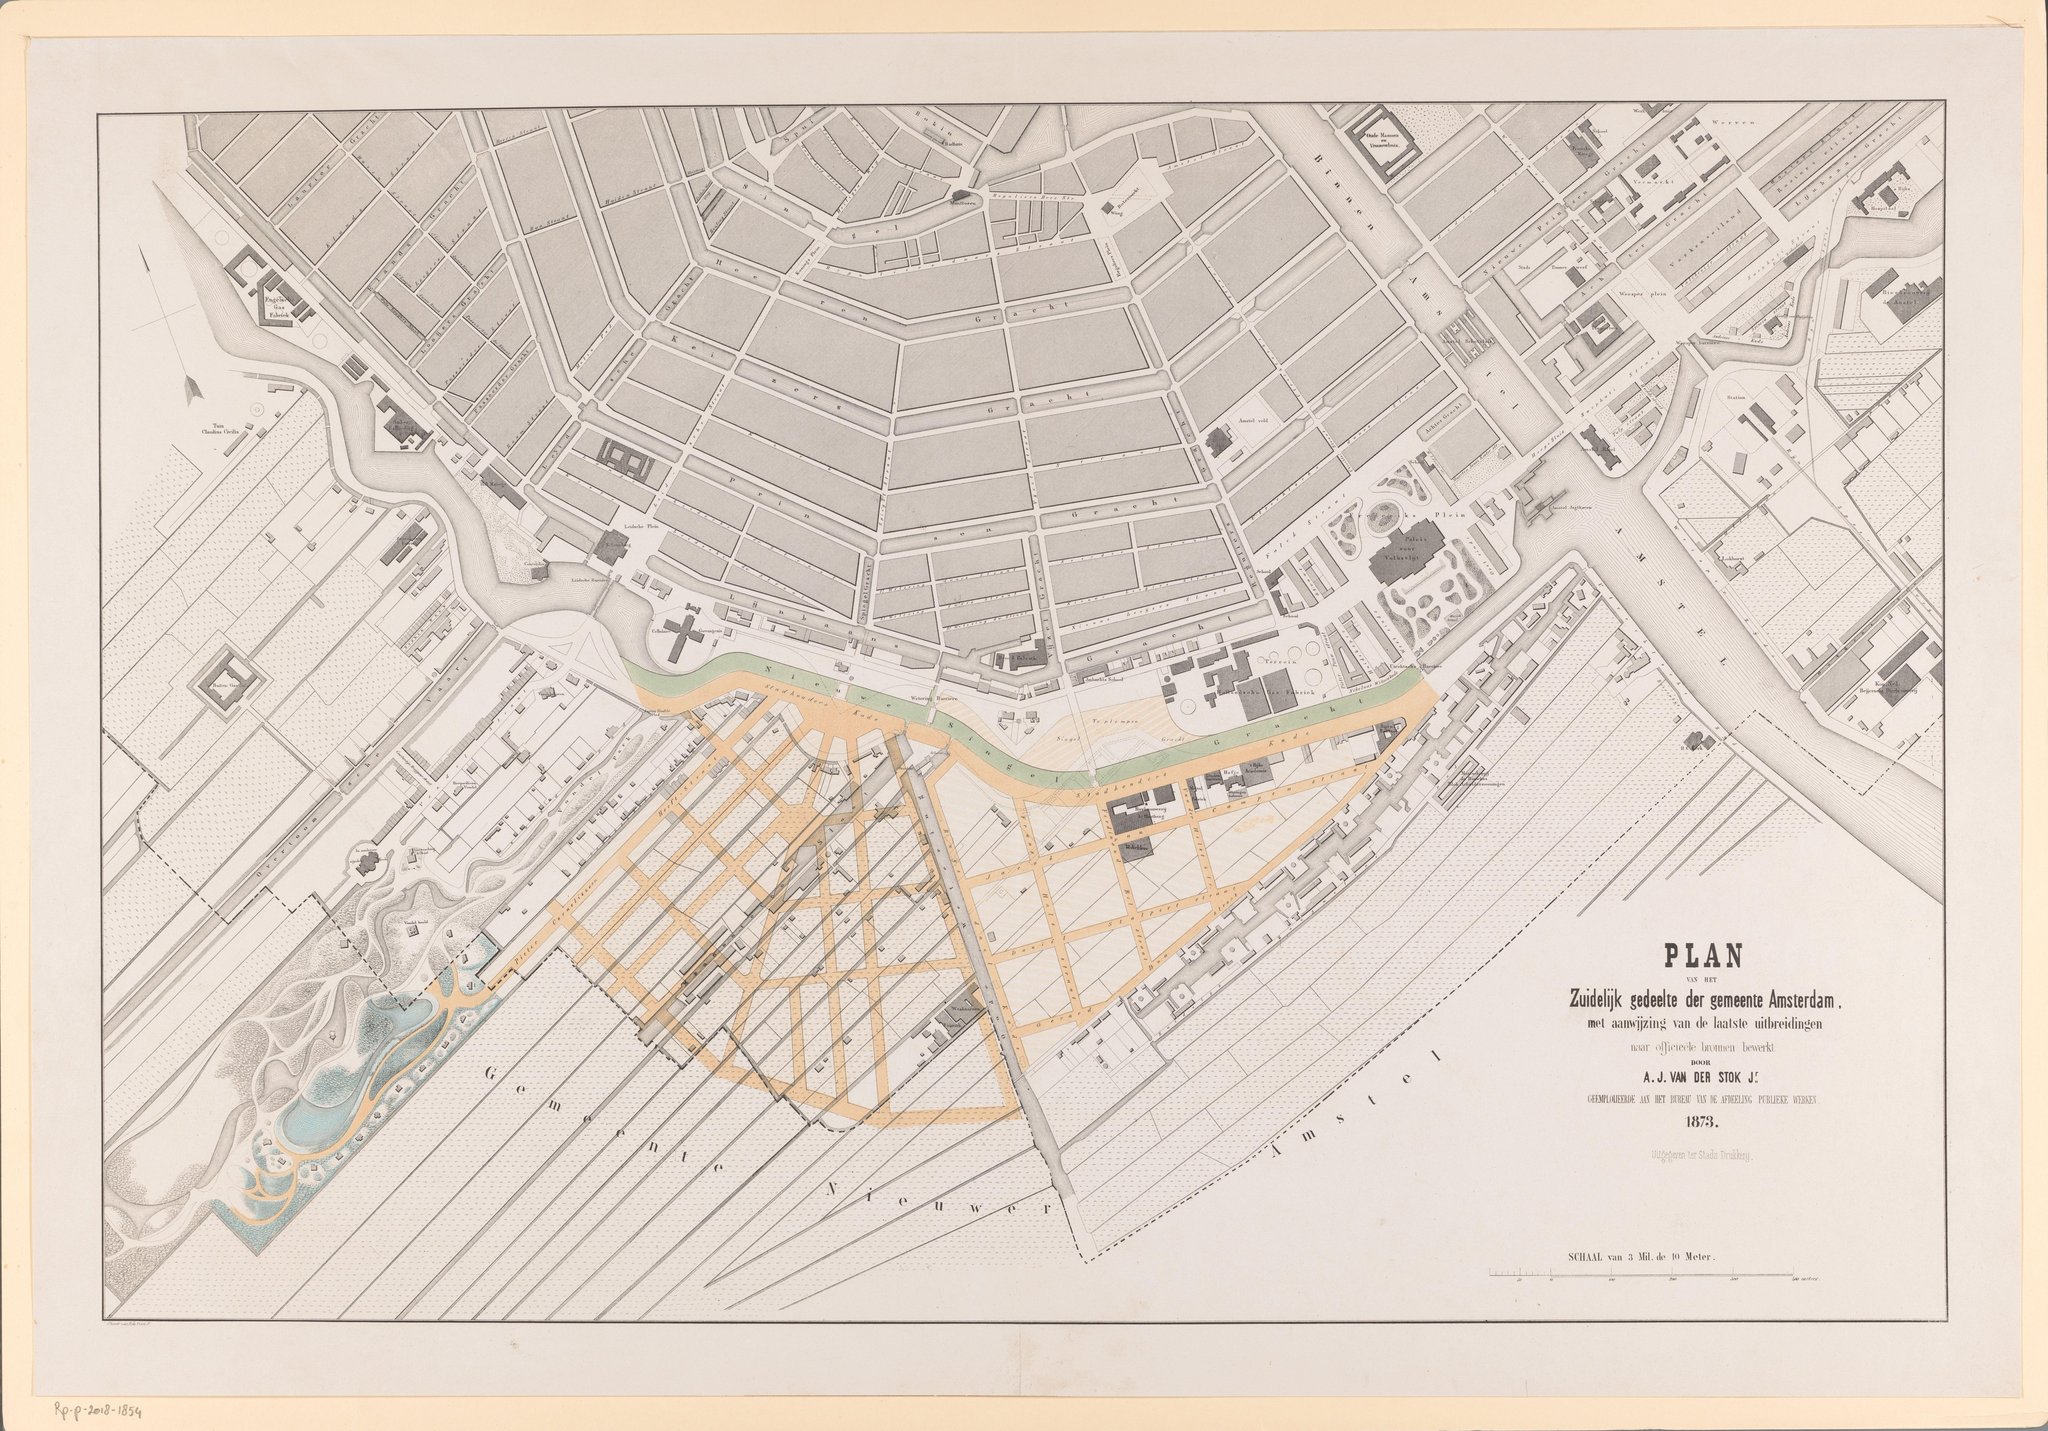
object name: print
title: Plattegrond van Amsterdam-Zuid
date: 1873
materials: paper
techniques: lithograph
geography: amsterdam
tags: maps of cities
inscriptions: date